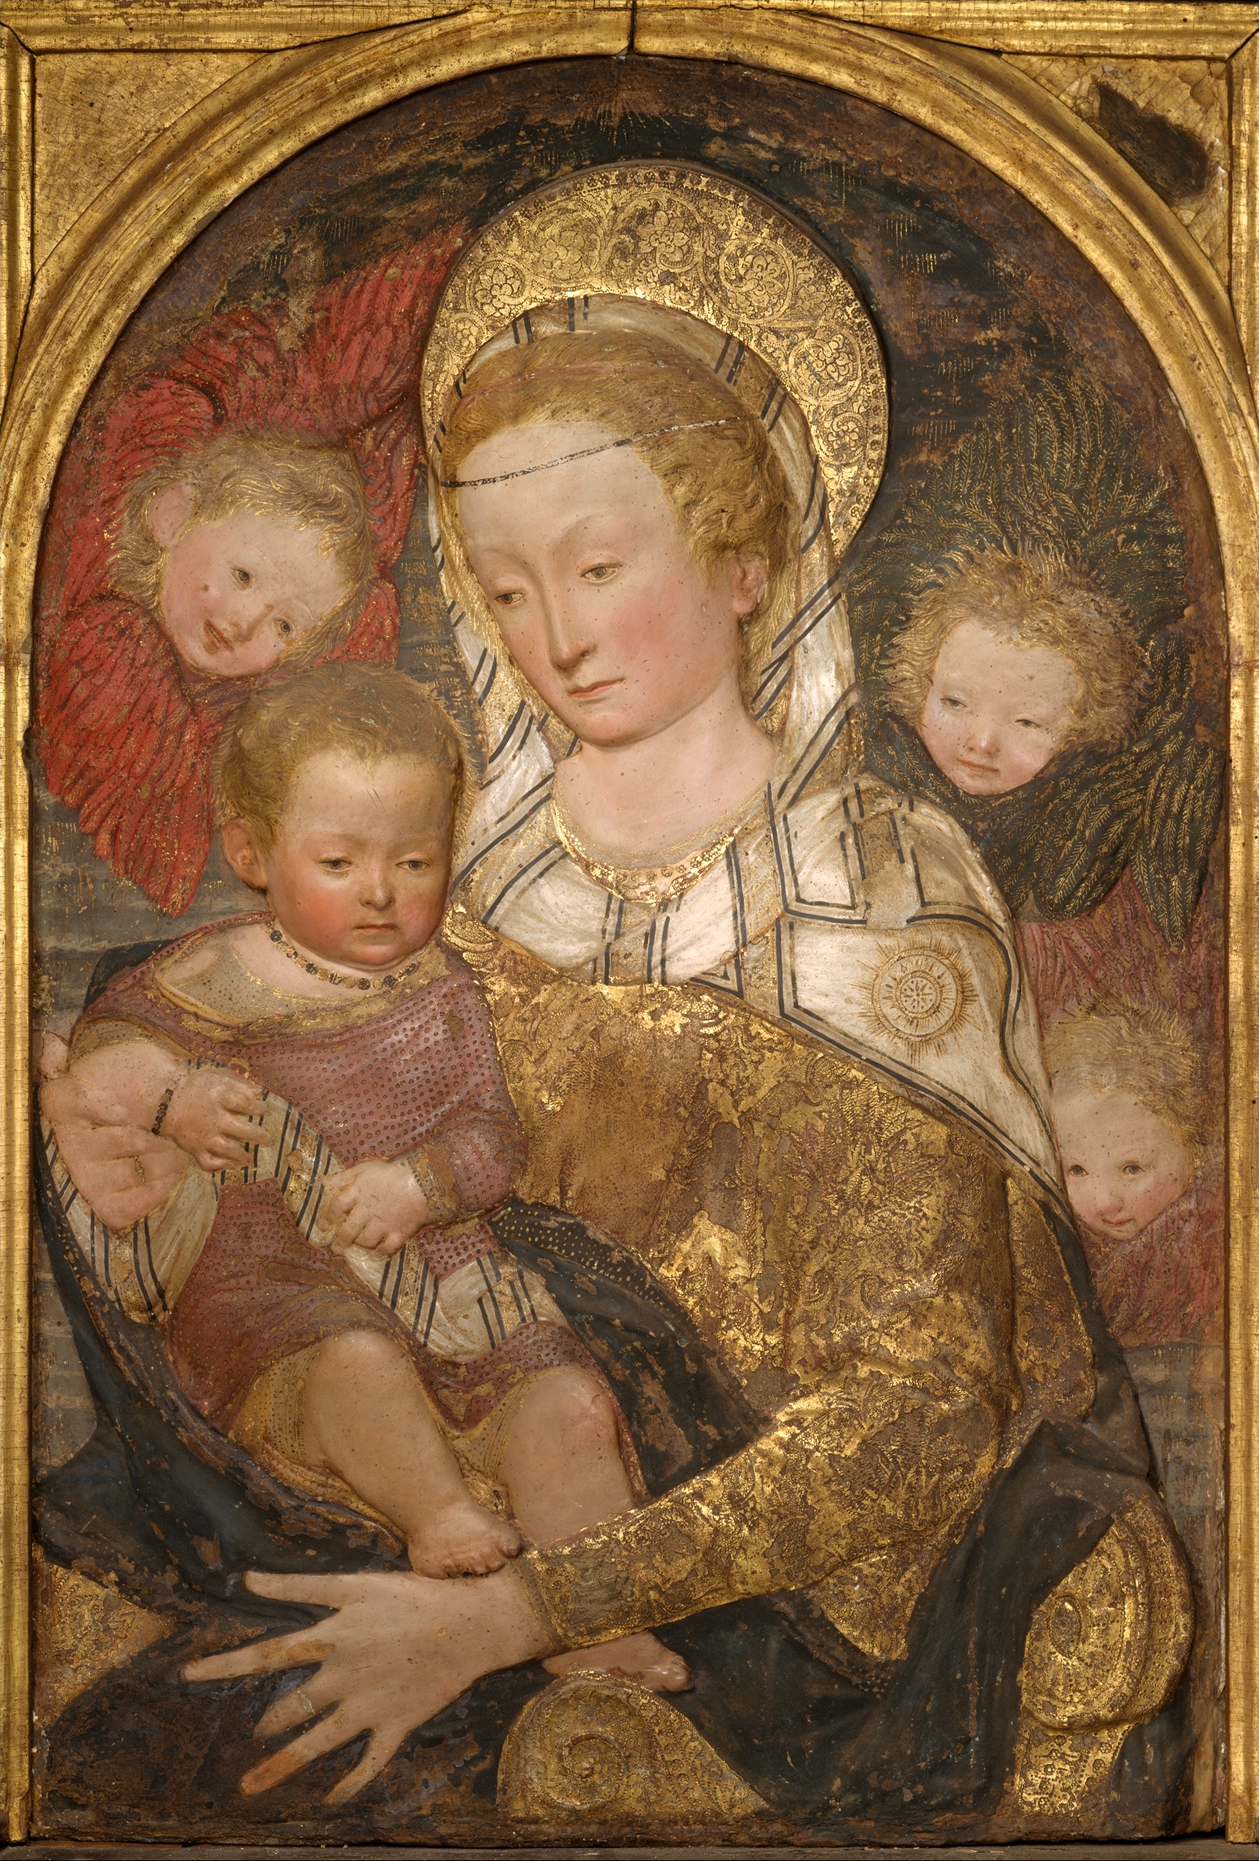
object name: relief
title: Madonna and Child with Angels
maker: antonio rossellino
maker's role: artist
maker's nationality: italian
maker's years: 1427-1479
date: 1451-1475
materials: gilt, plaster, wood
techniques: painting, relief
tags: angels,madonna and child